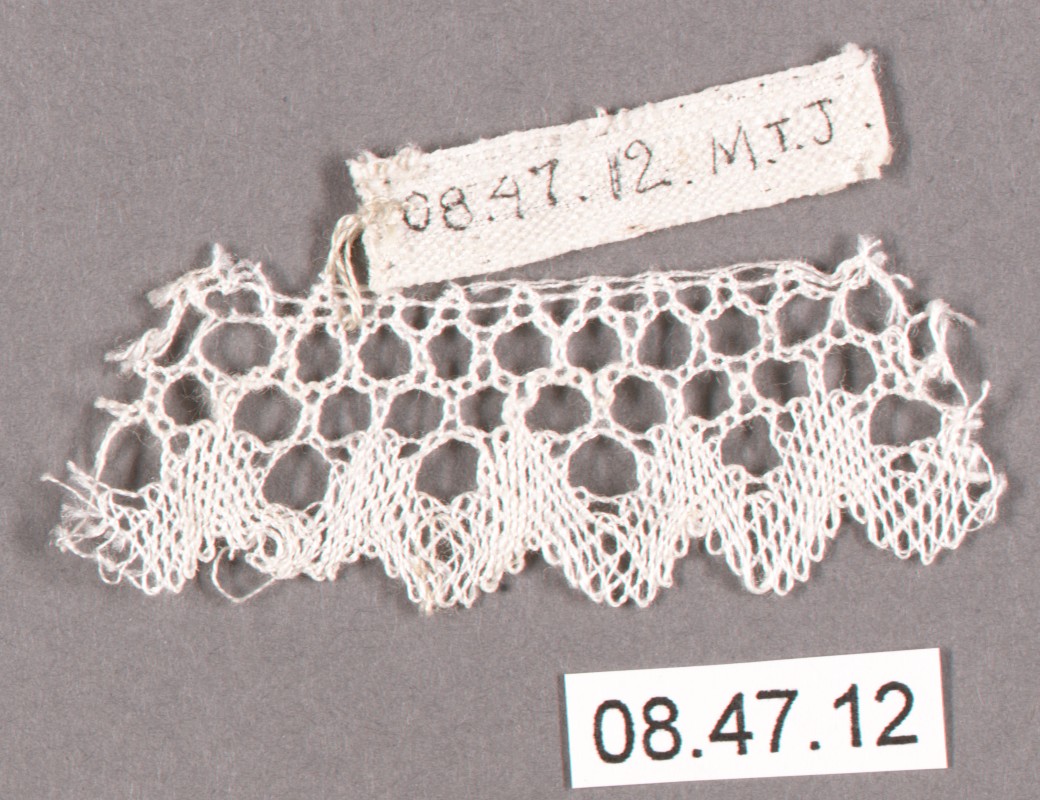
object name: fragment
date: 1801-1900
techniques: lace